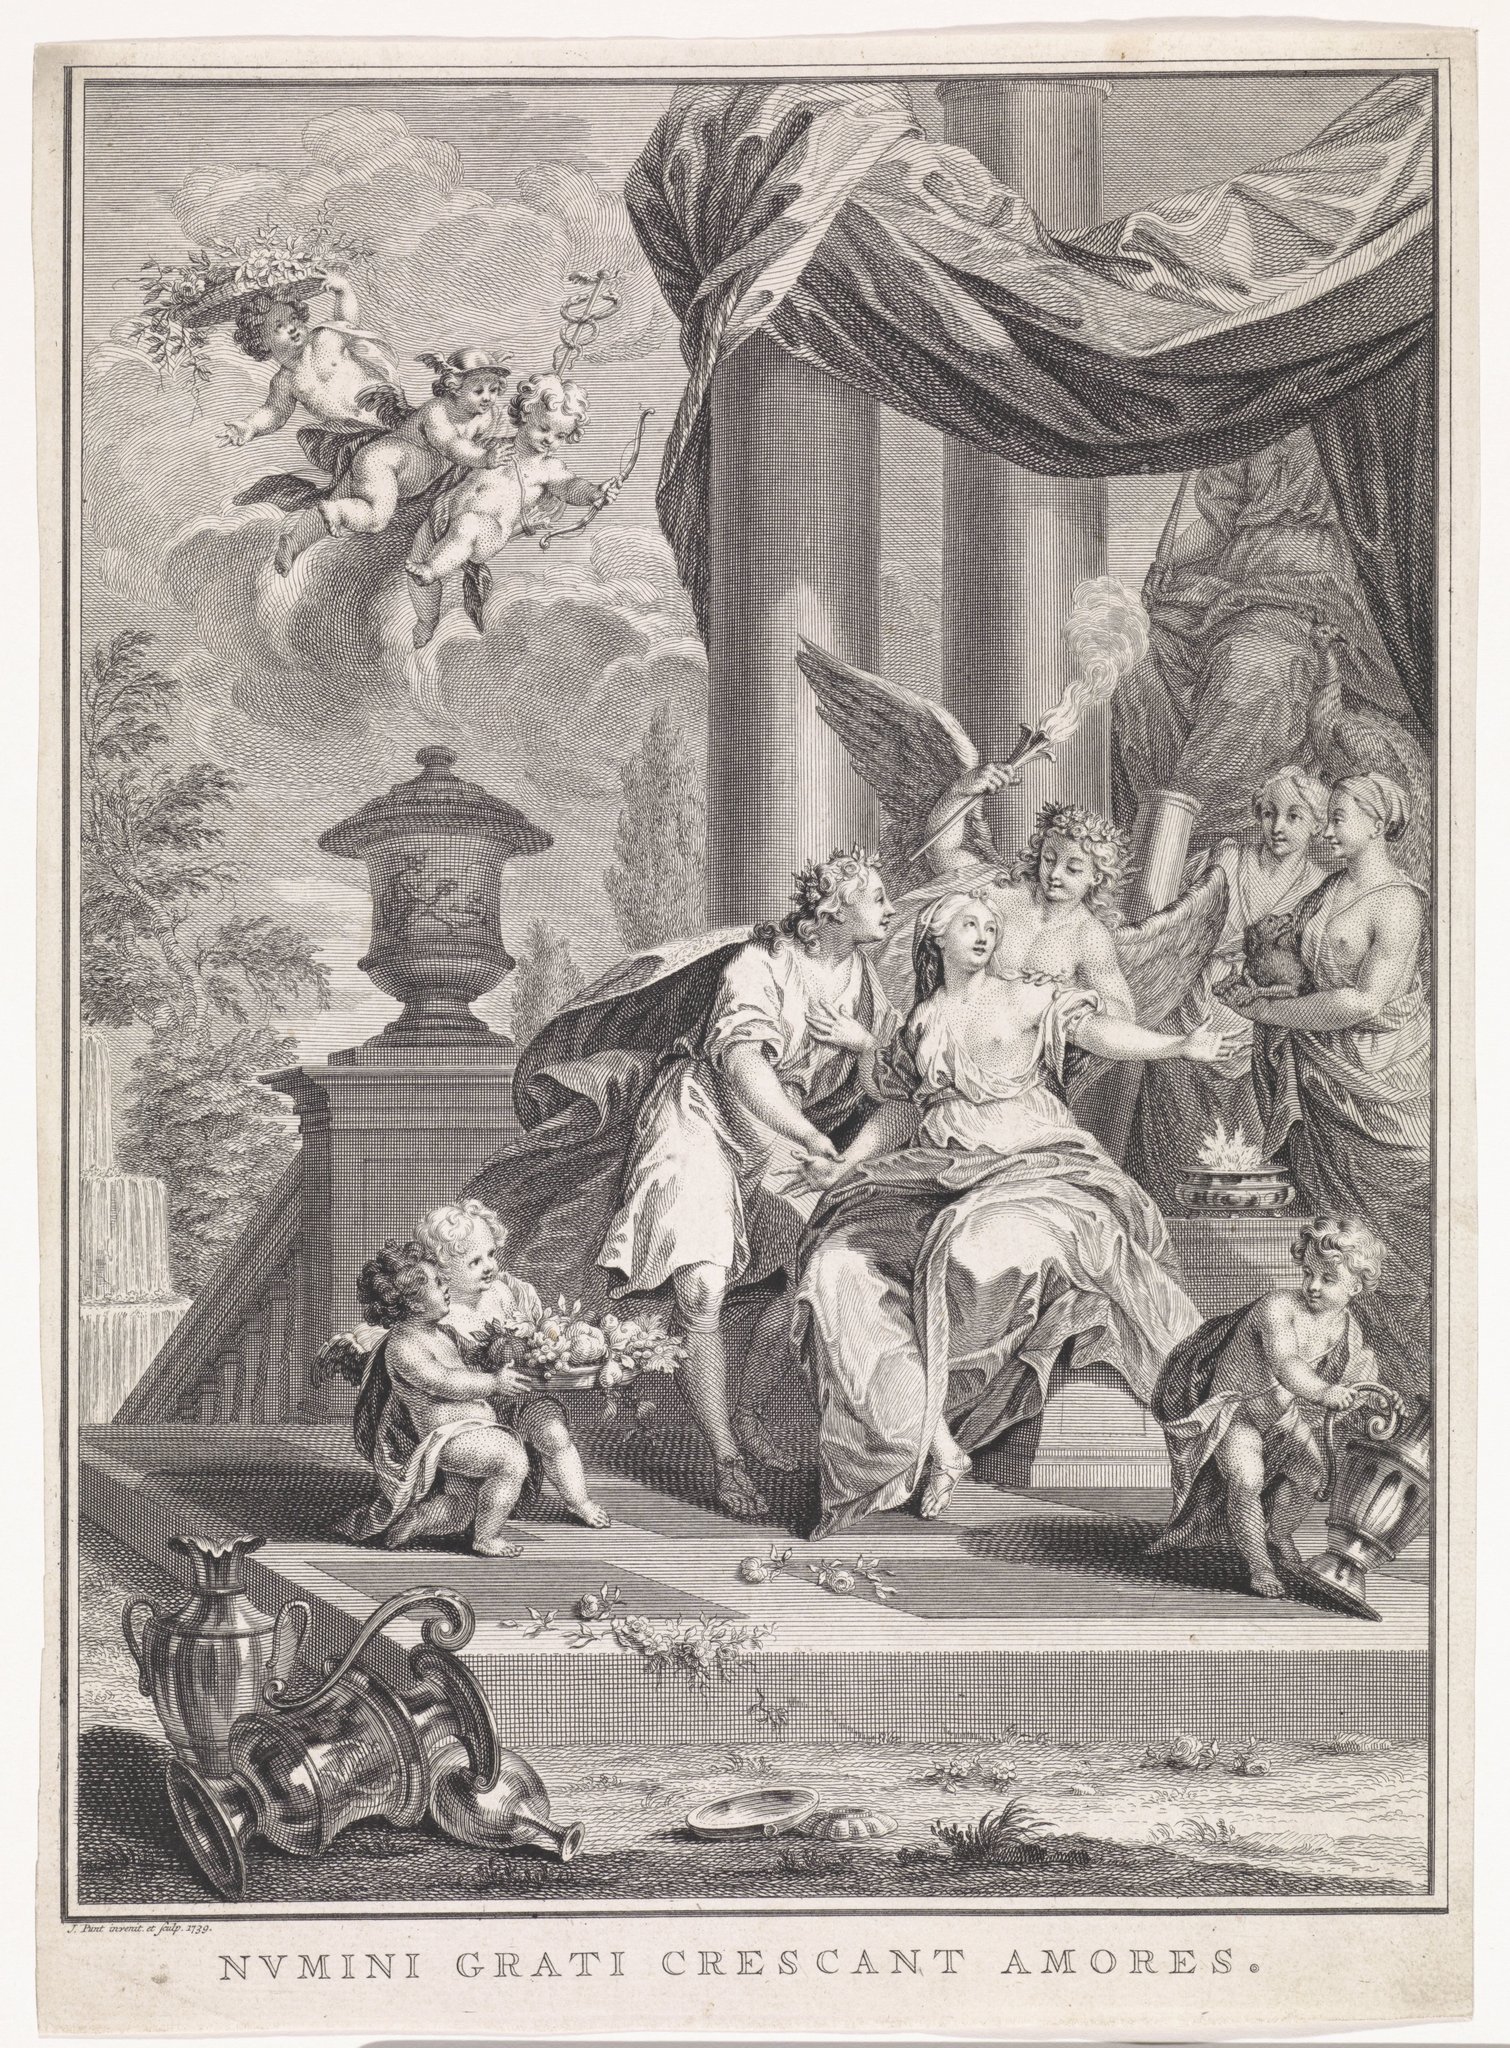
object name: print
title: Liefdespaar in tempel van Juno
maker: jan punt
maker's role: draughtsman, print maker, publisher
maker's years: 1711-1779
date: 1739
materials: paper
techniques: engraving, etching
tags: (story of) hymen(aeus), (story of) cupid, amor (eros), perseverance, resolution, determination; 'perseveranza' (ripa), carefulness, diligence; 'diligenza' (ripa), couple of lovers, temple, shrine ~ greek religion, juno iuga, juno pronuba, protectress of marriage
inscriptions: collector's mark: Lugt 2228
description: Een liefdespaar zit in de tempel van Juno, de godin die waakt over het huwelijk. Twee putti presenteren hen een mand gevuld met bloemen en fruit. Rond het altaar achter hen staan Trouw (met hond), Standvastigheid (met zuil), die de huwelijkse deugden symboliseren, en de huwelijksgod Hymen. In de lucht vliegt Amor, vergezeld door twee putti, één met de attributen van Mercurius, de ander met een bloemenmand.